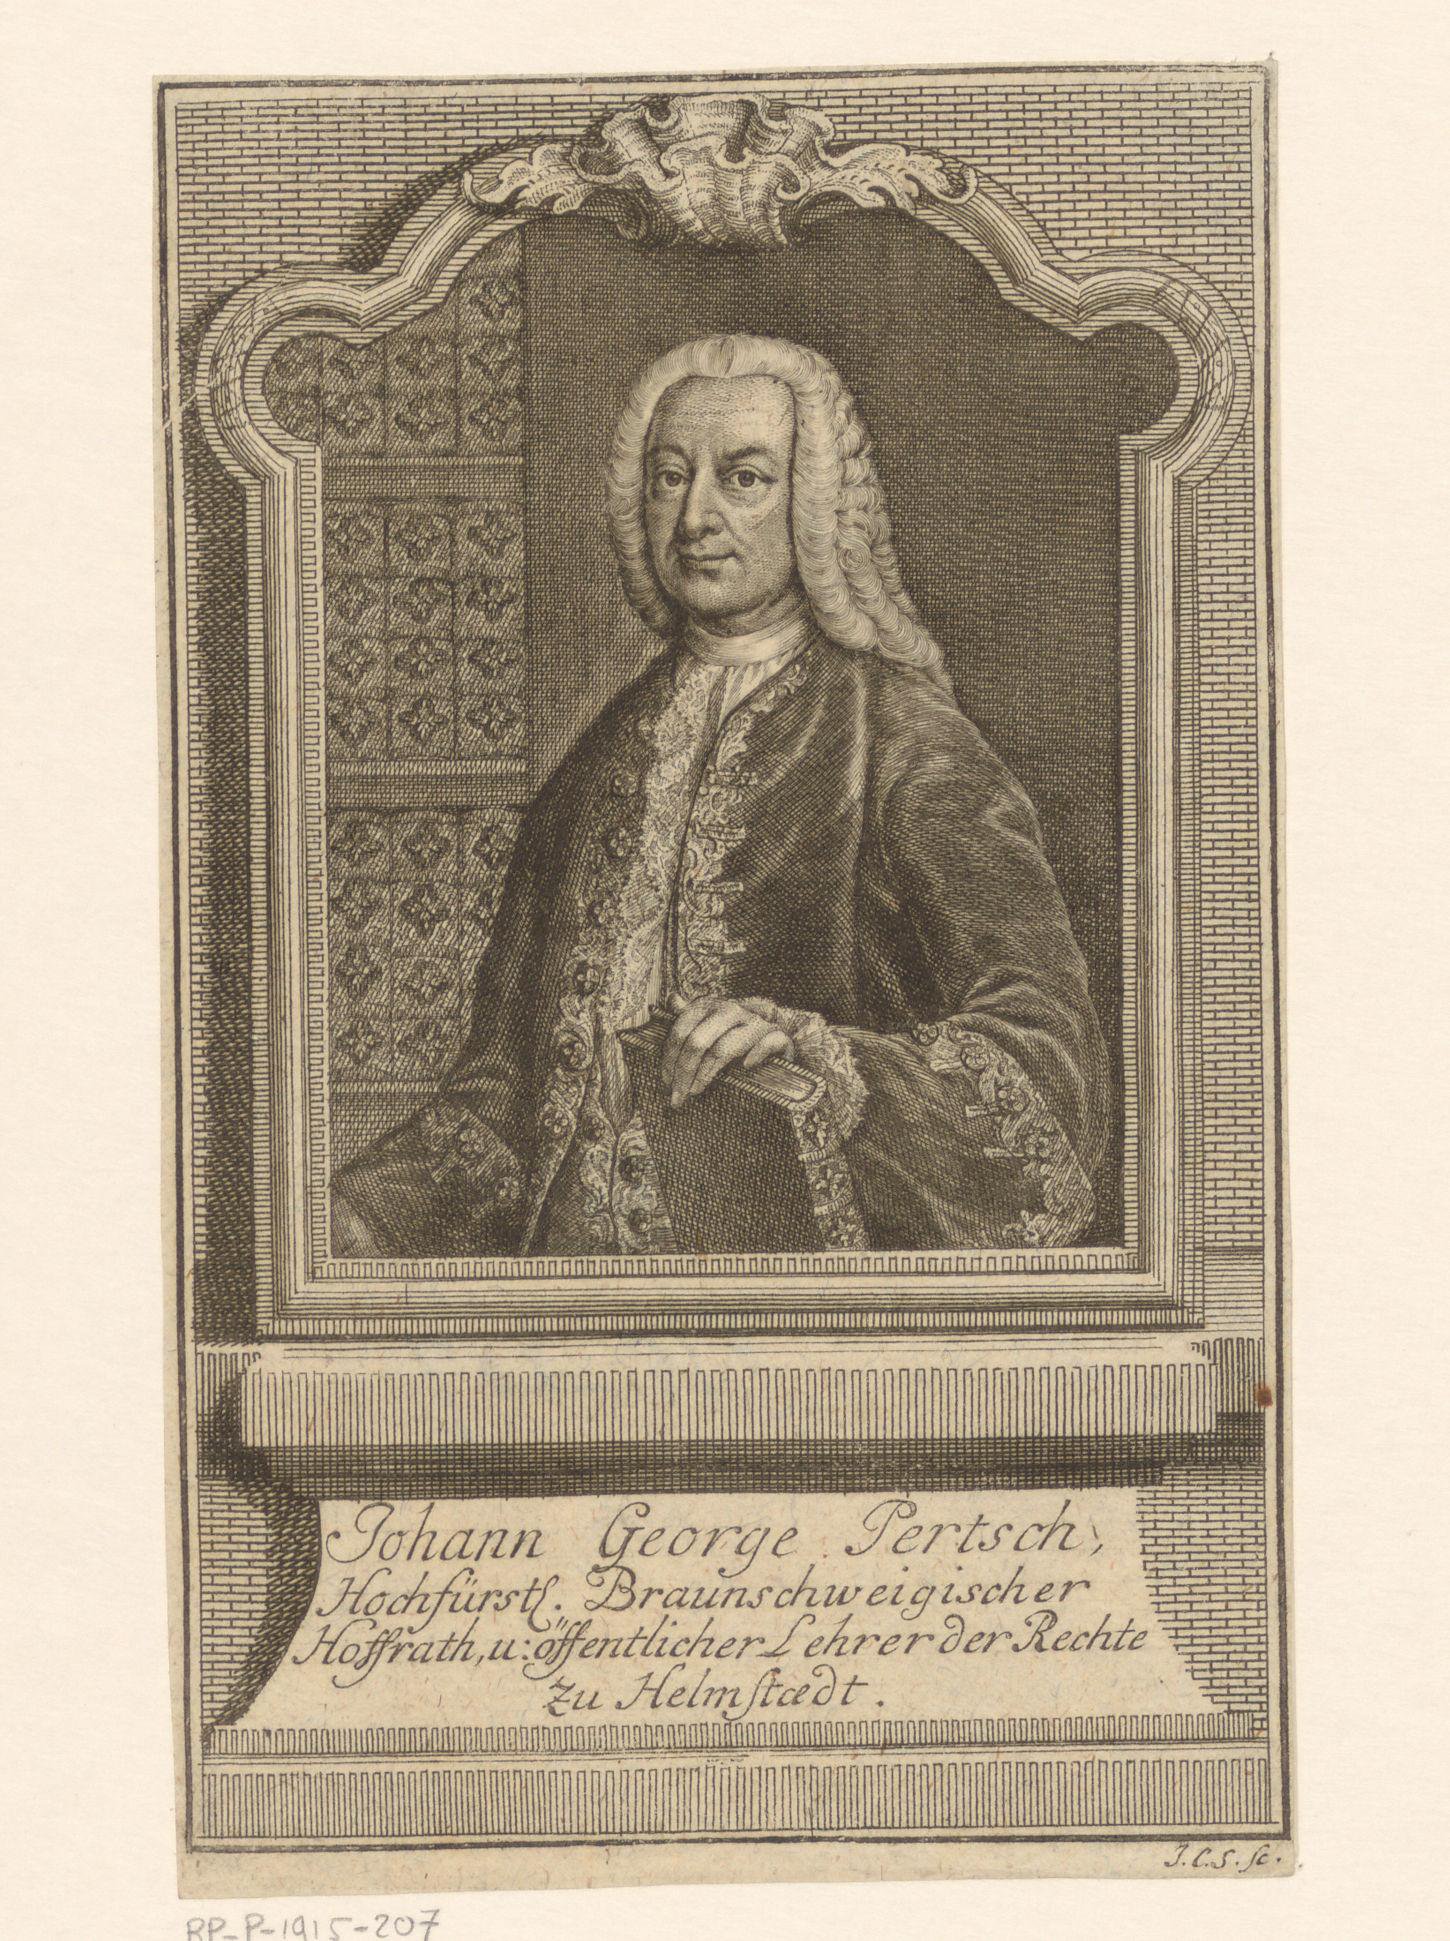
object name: print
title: Portret van Johann Georg Pertsch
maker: johann christoph sysang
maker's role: print maker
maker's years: 1703-1757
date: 1754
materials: paper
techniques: engraving, etching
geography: leipzig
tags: bookshelves, historical persons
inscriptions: collector's mark: Lugt 2228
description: Prent gebruikt voor de publicatie: Zuverlässige Nachrichten von dem gegenwärtigen Zustande, Veränderung und Wachsthum der Wissenschaften. Leipzig: Johann Friedrich Gleditsch, 1754, dl. 174.